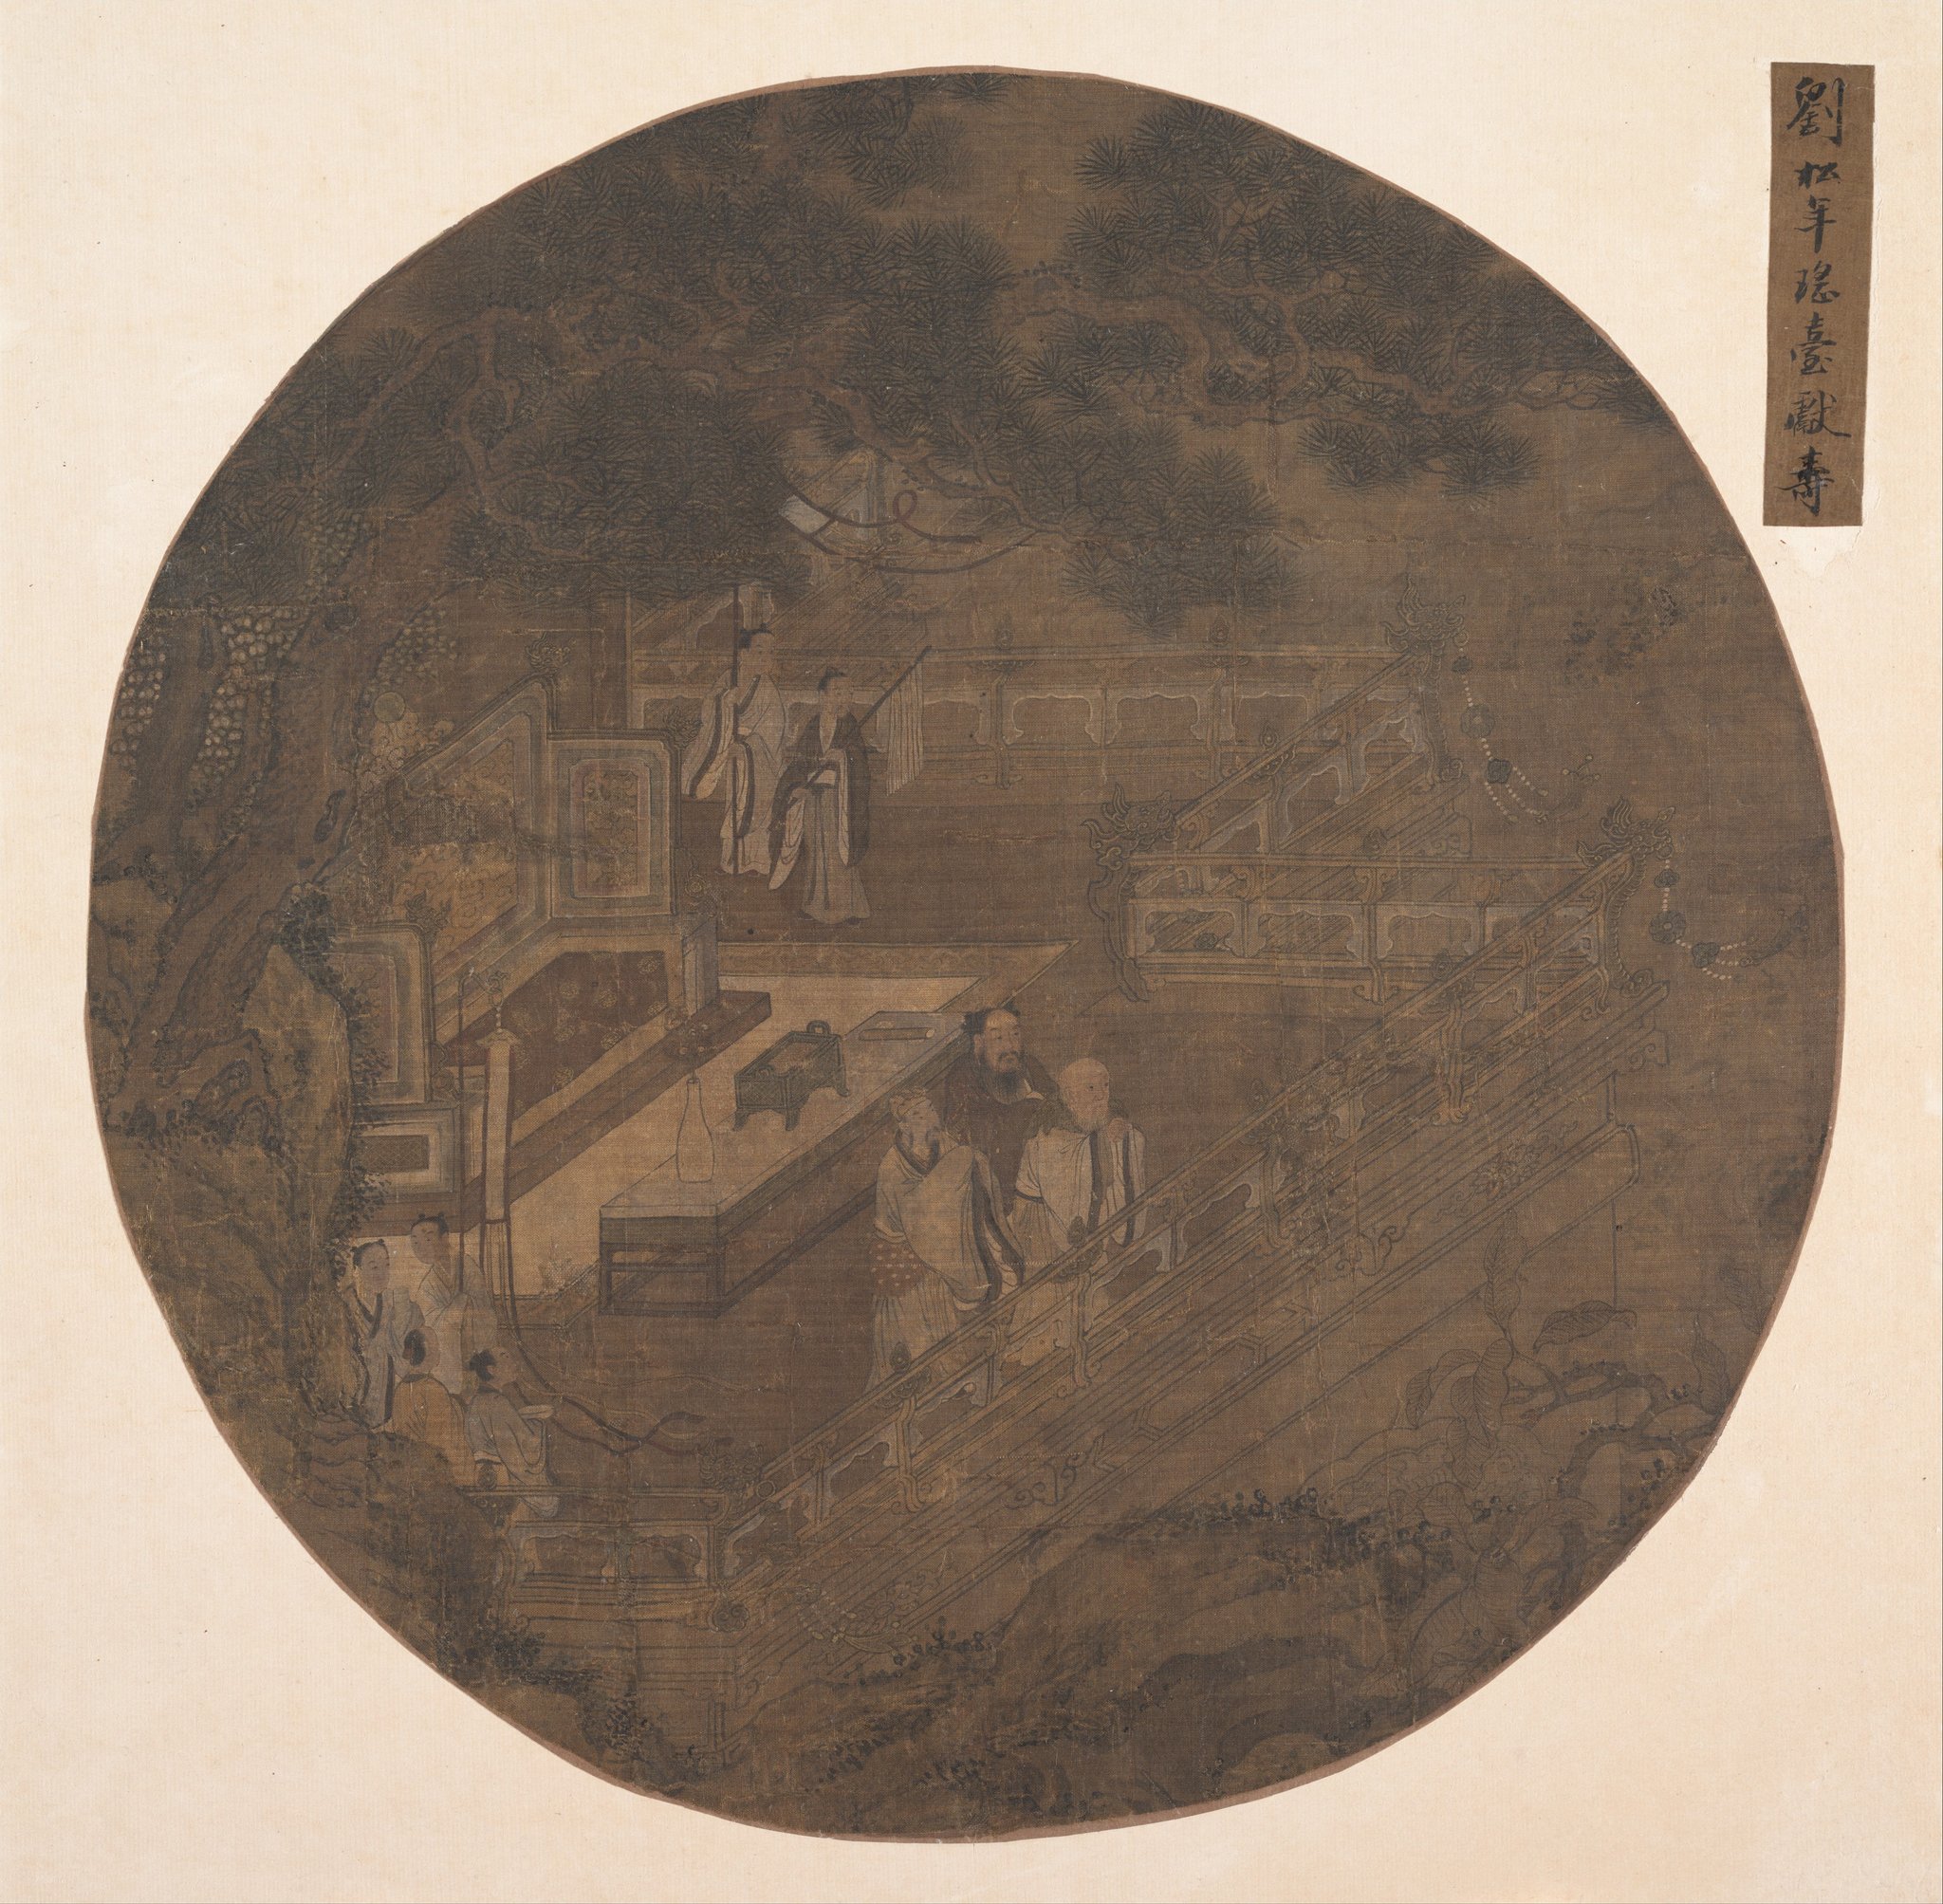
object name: fan mounted a an album leaf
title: Paying homage to Xiwangmu, the Queen Mother of the West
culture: chinese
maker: unidentified artist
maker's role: artist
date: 1401-1500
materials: ink, silk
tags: men,tables